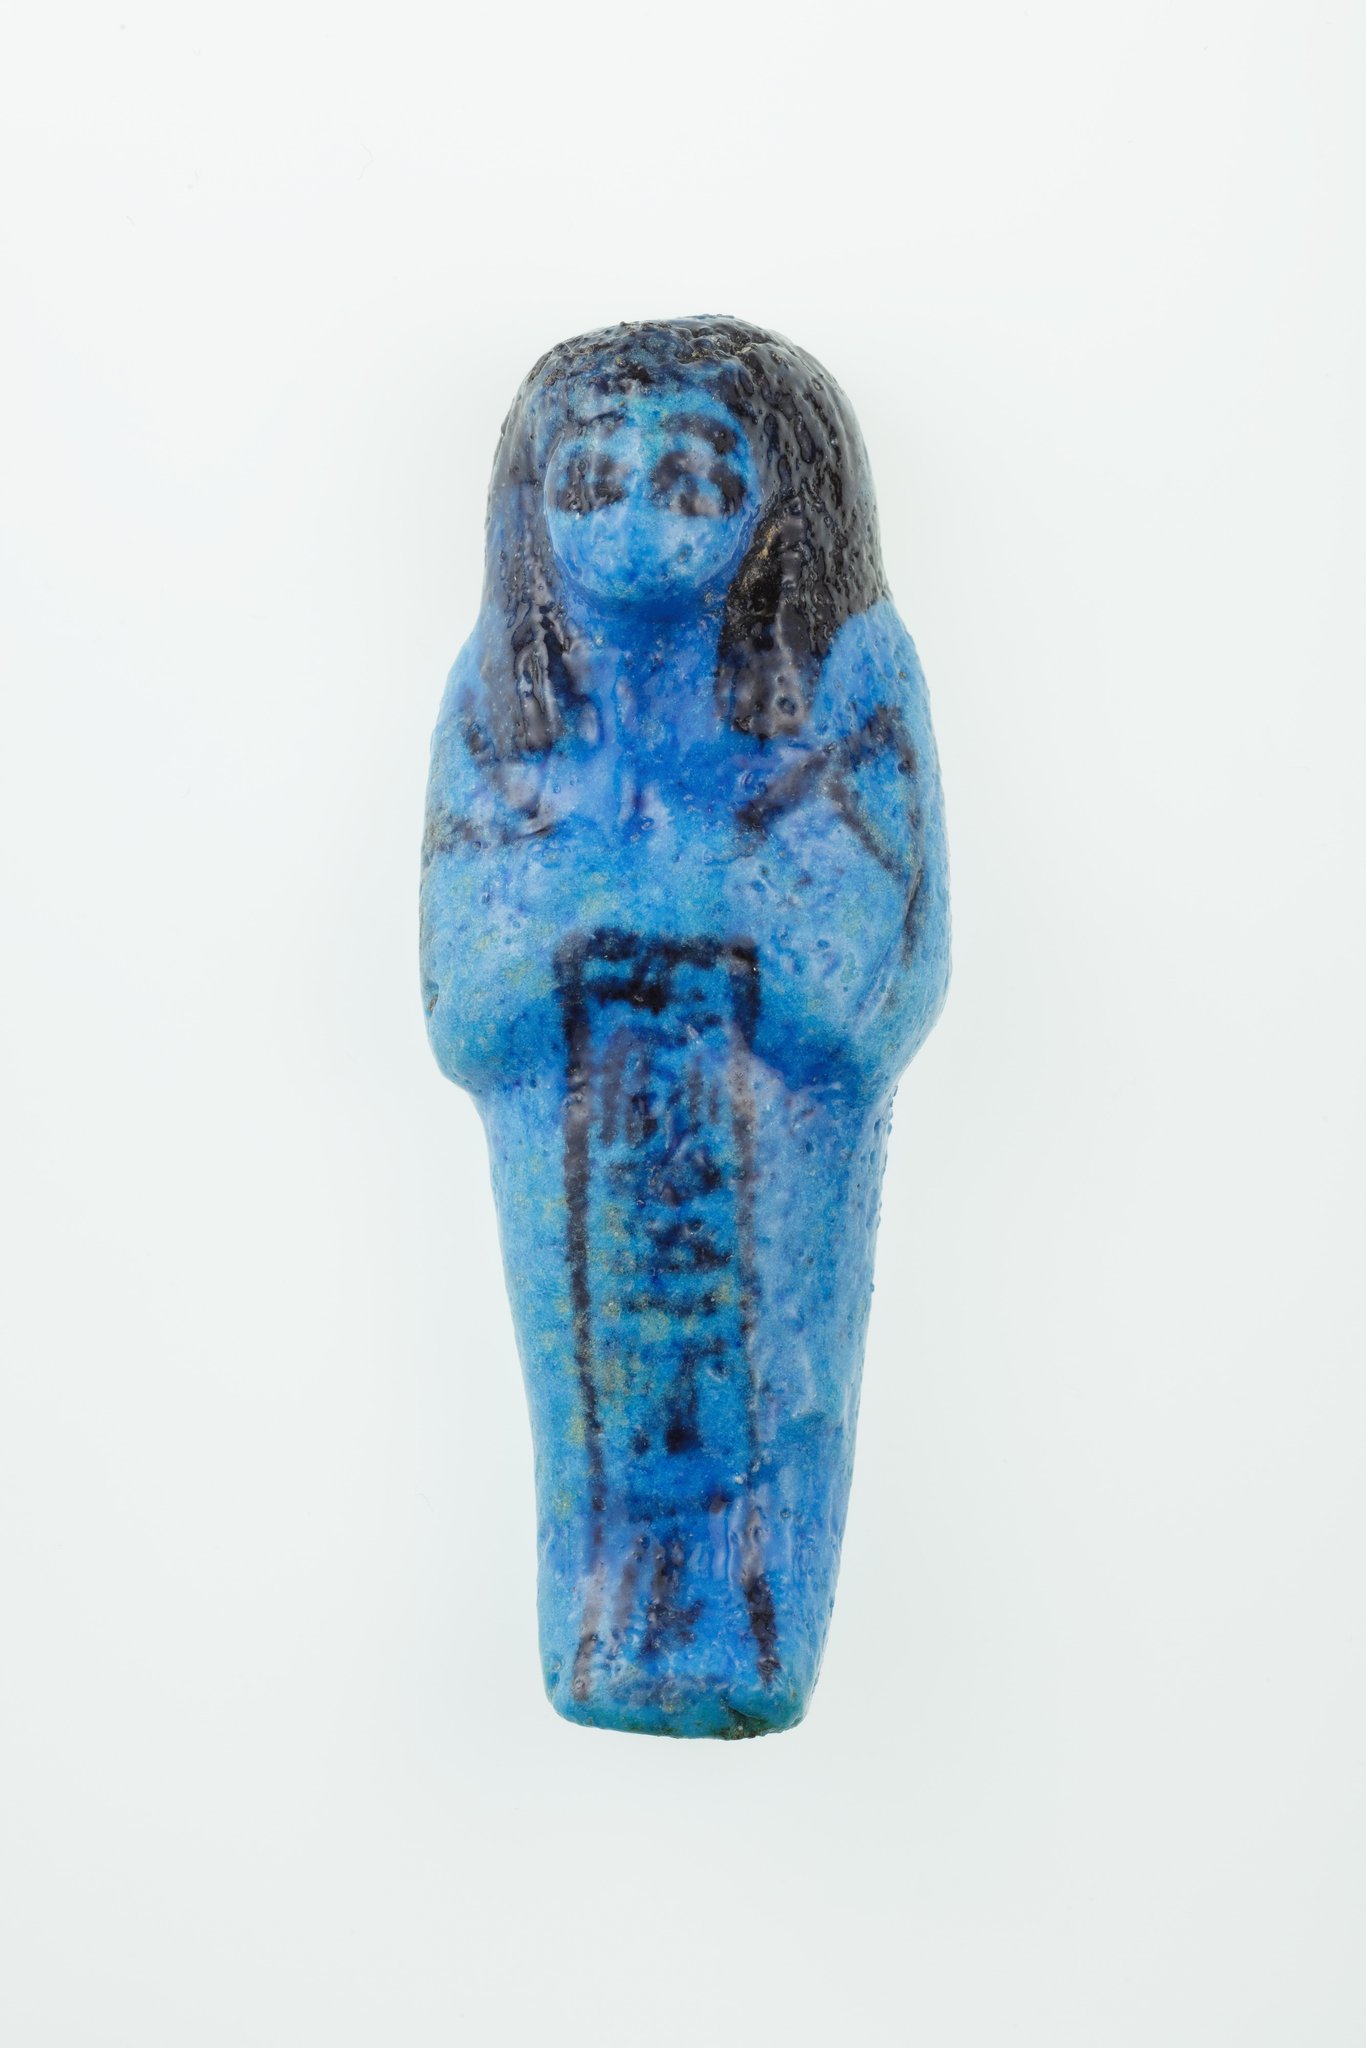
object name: shabti, worker, nauny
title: Worker Shabti of Nauny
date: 1050 BCE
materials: faience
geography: egypt